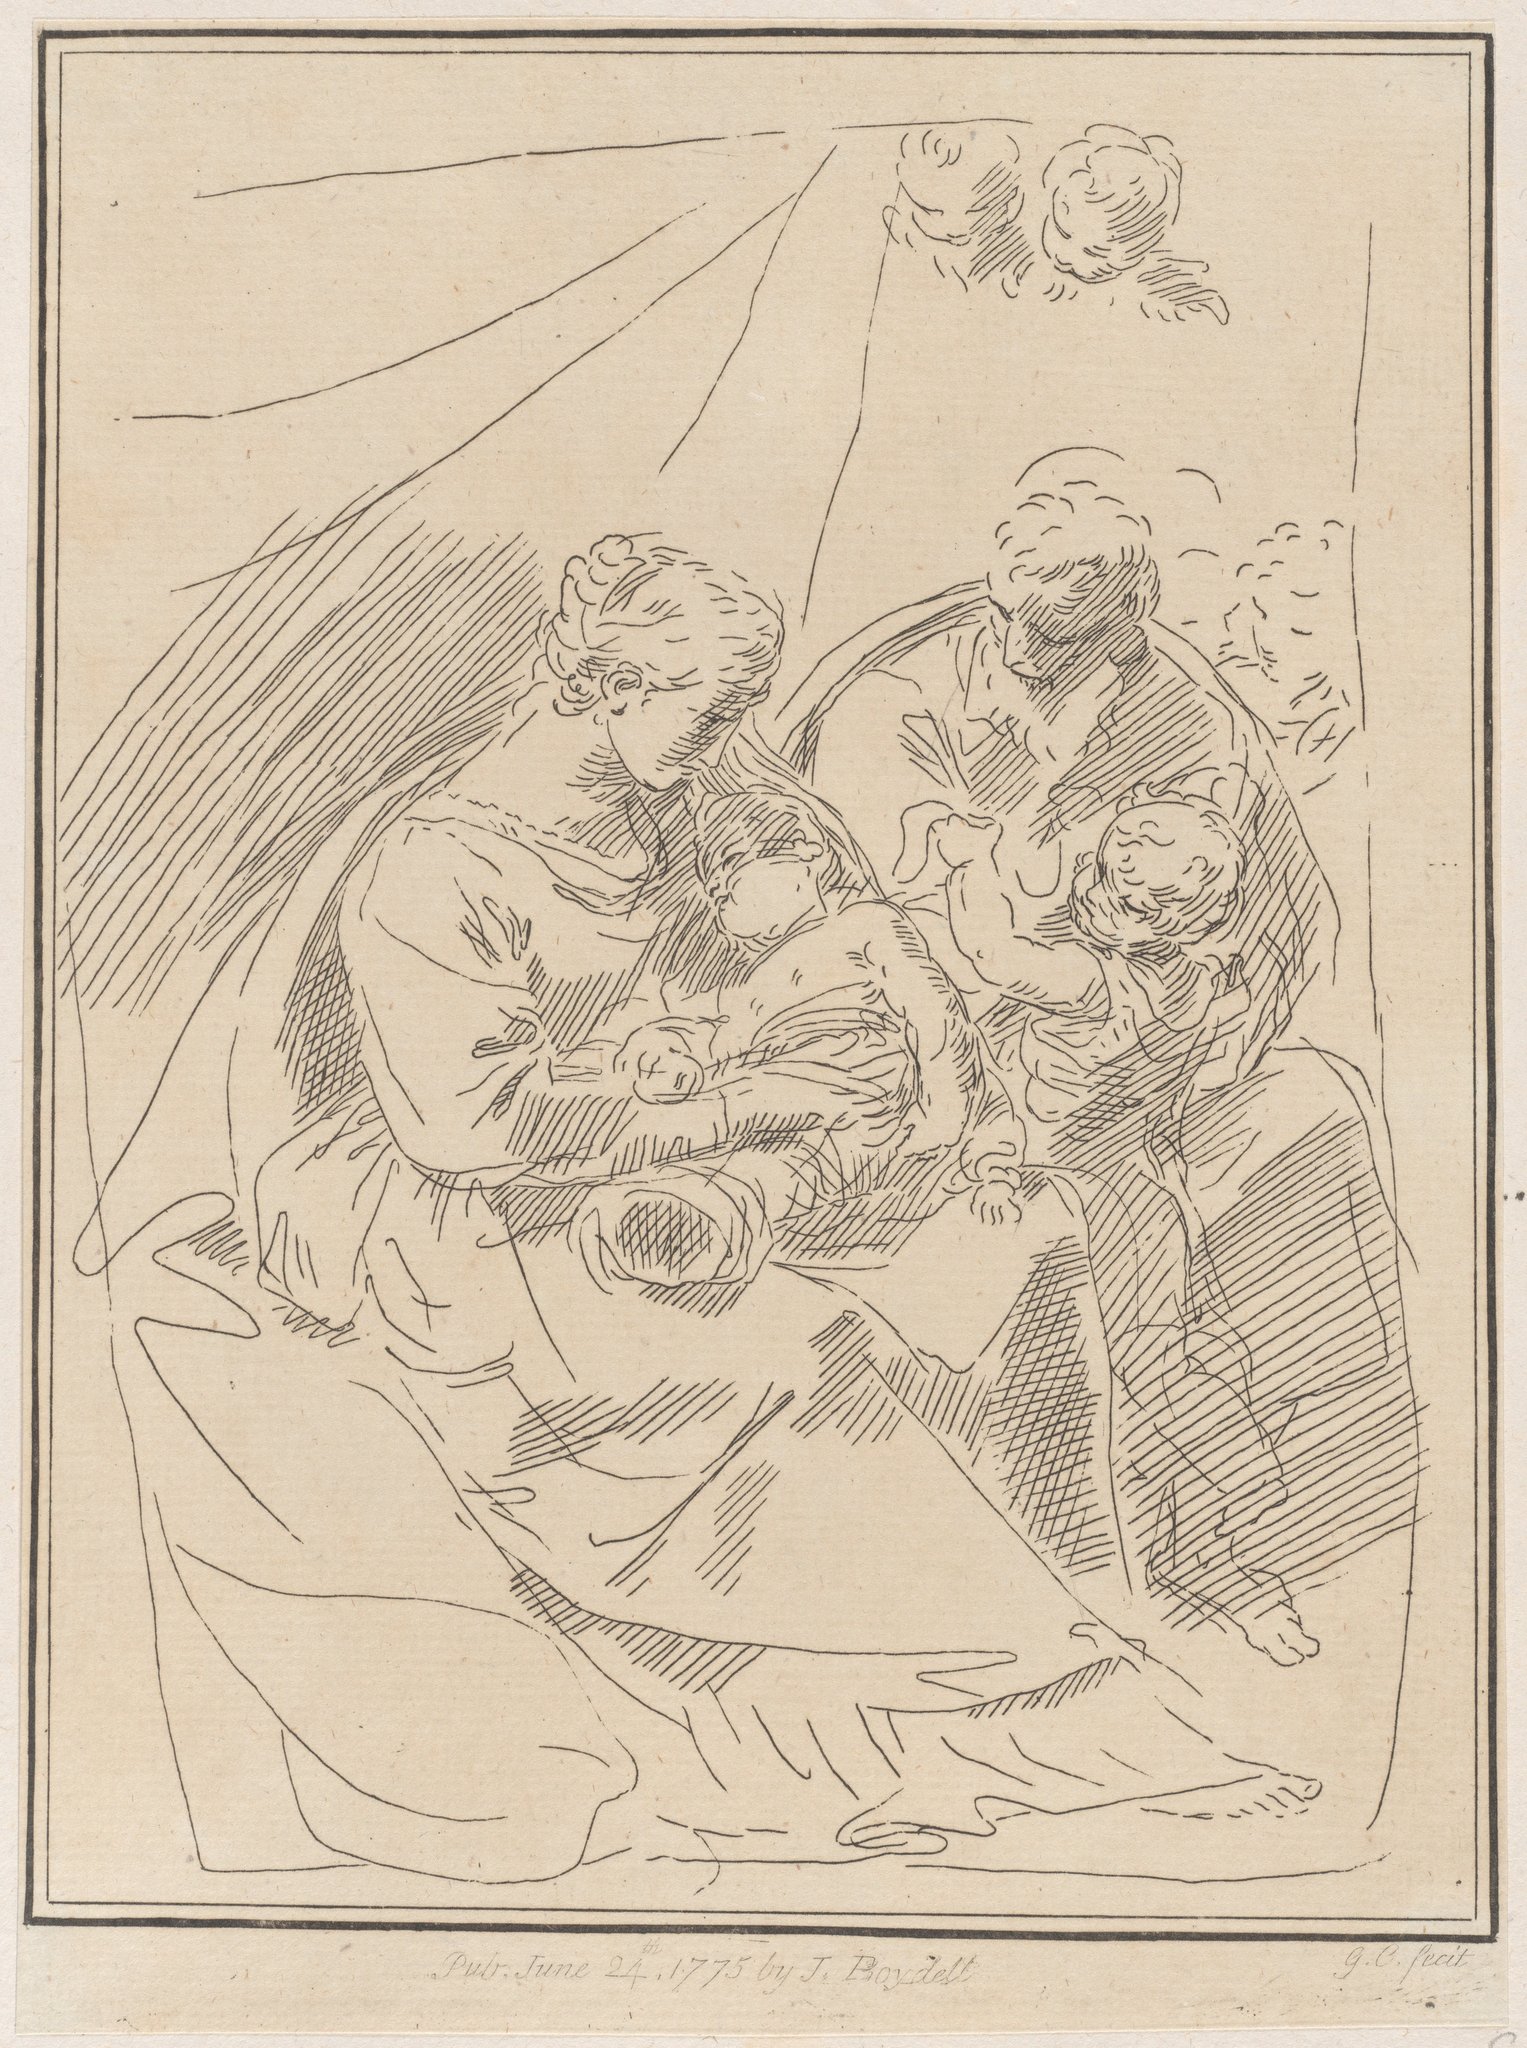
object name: print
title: The Holy Family with the infant Saint John the Baptist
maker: giuseppe canale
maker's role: artist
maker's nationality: italian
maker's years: 1725-1802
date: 1775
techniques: etching